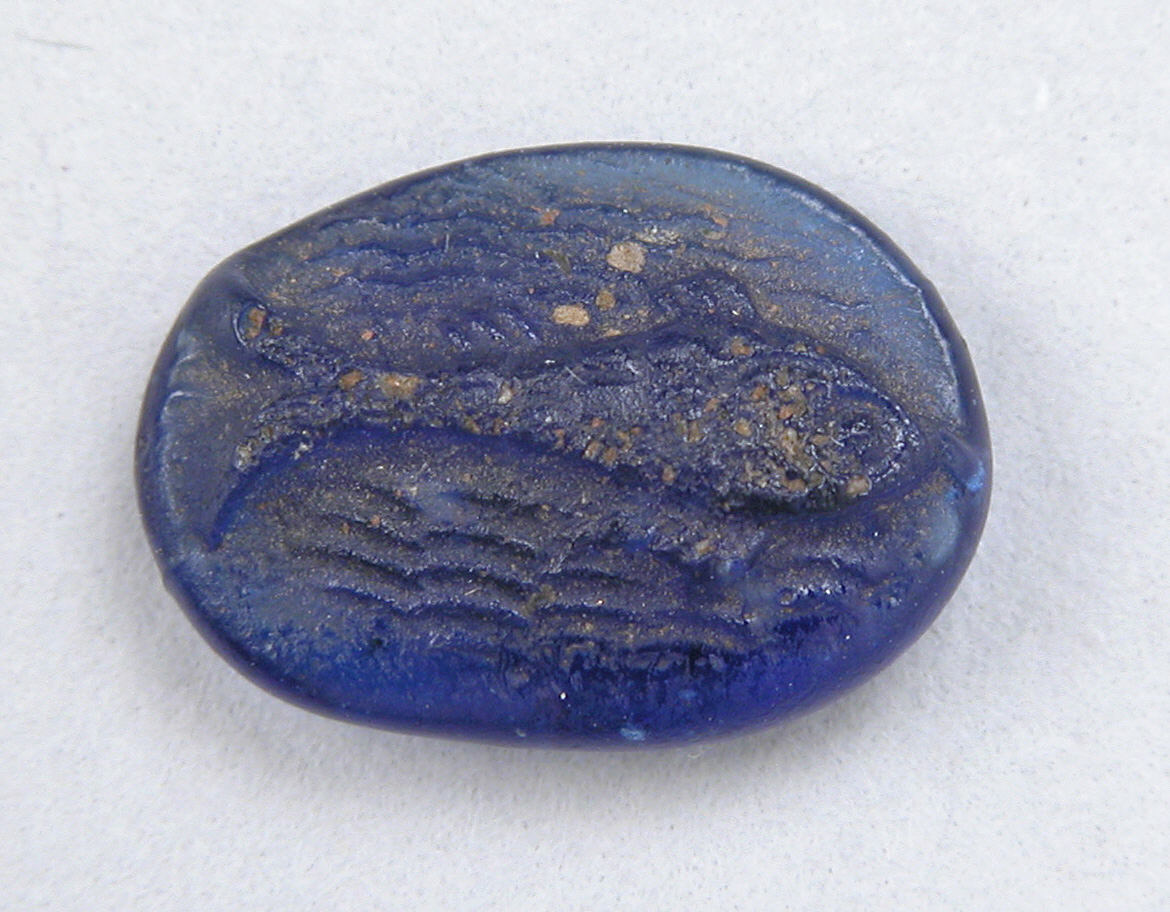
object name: disk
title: Disk with Fish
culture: byzantine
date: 501-700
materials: glass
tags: fish